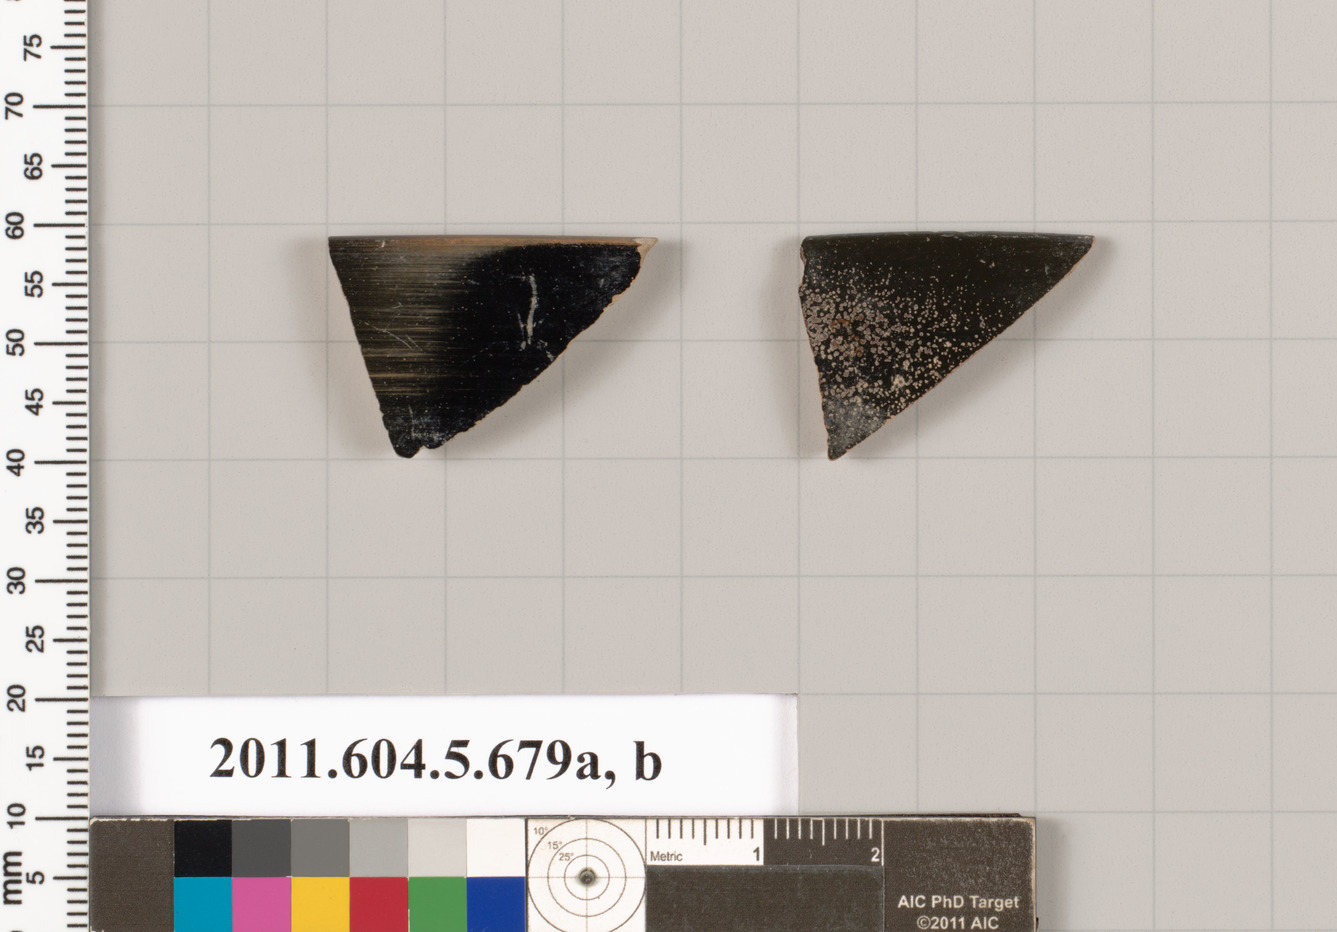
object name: kylix fragment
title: Terracotta rim fragments of kylikes (drinking cups)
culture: greek, attic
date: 600-401 BCE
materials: terracotta